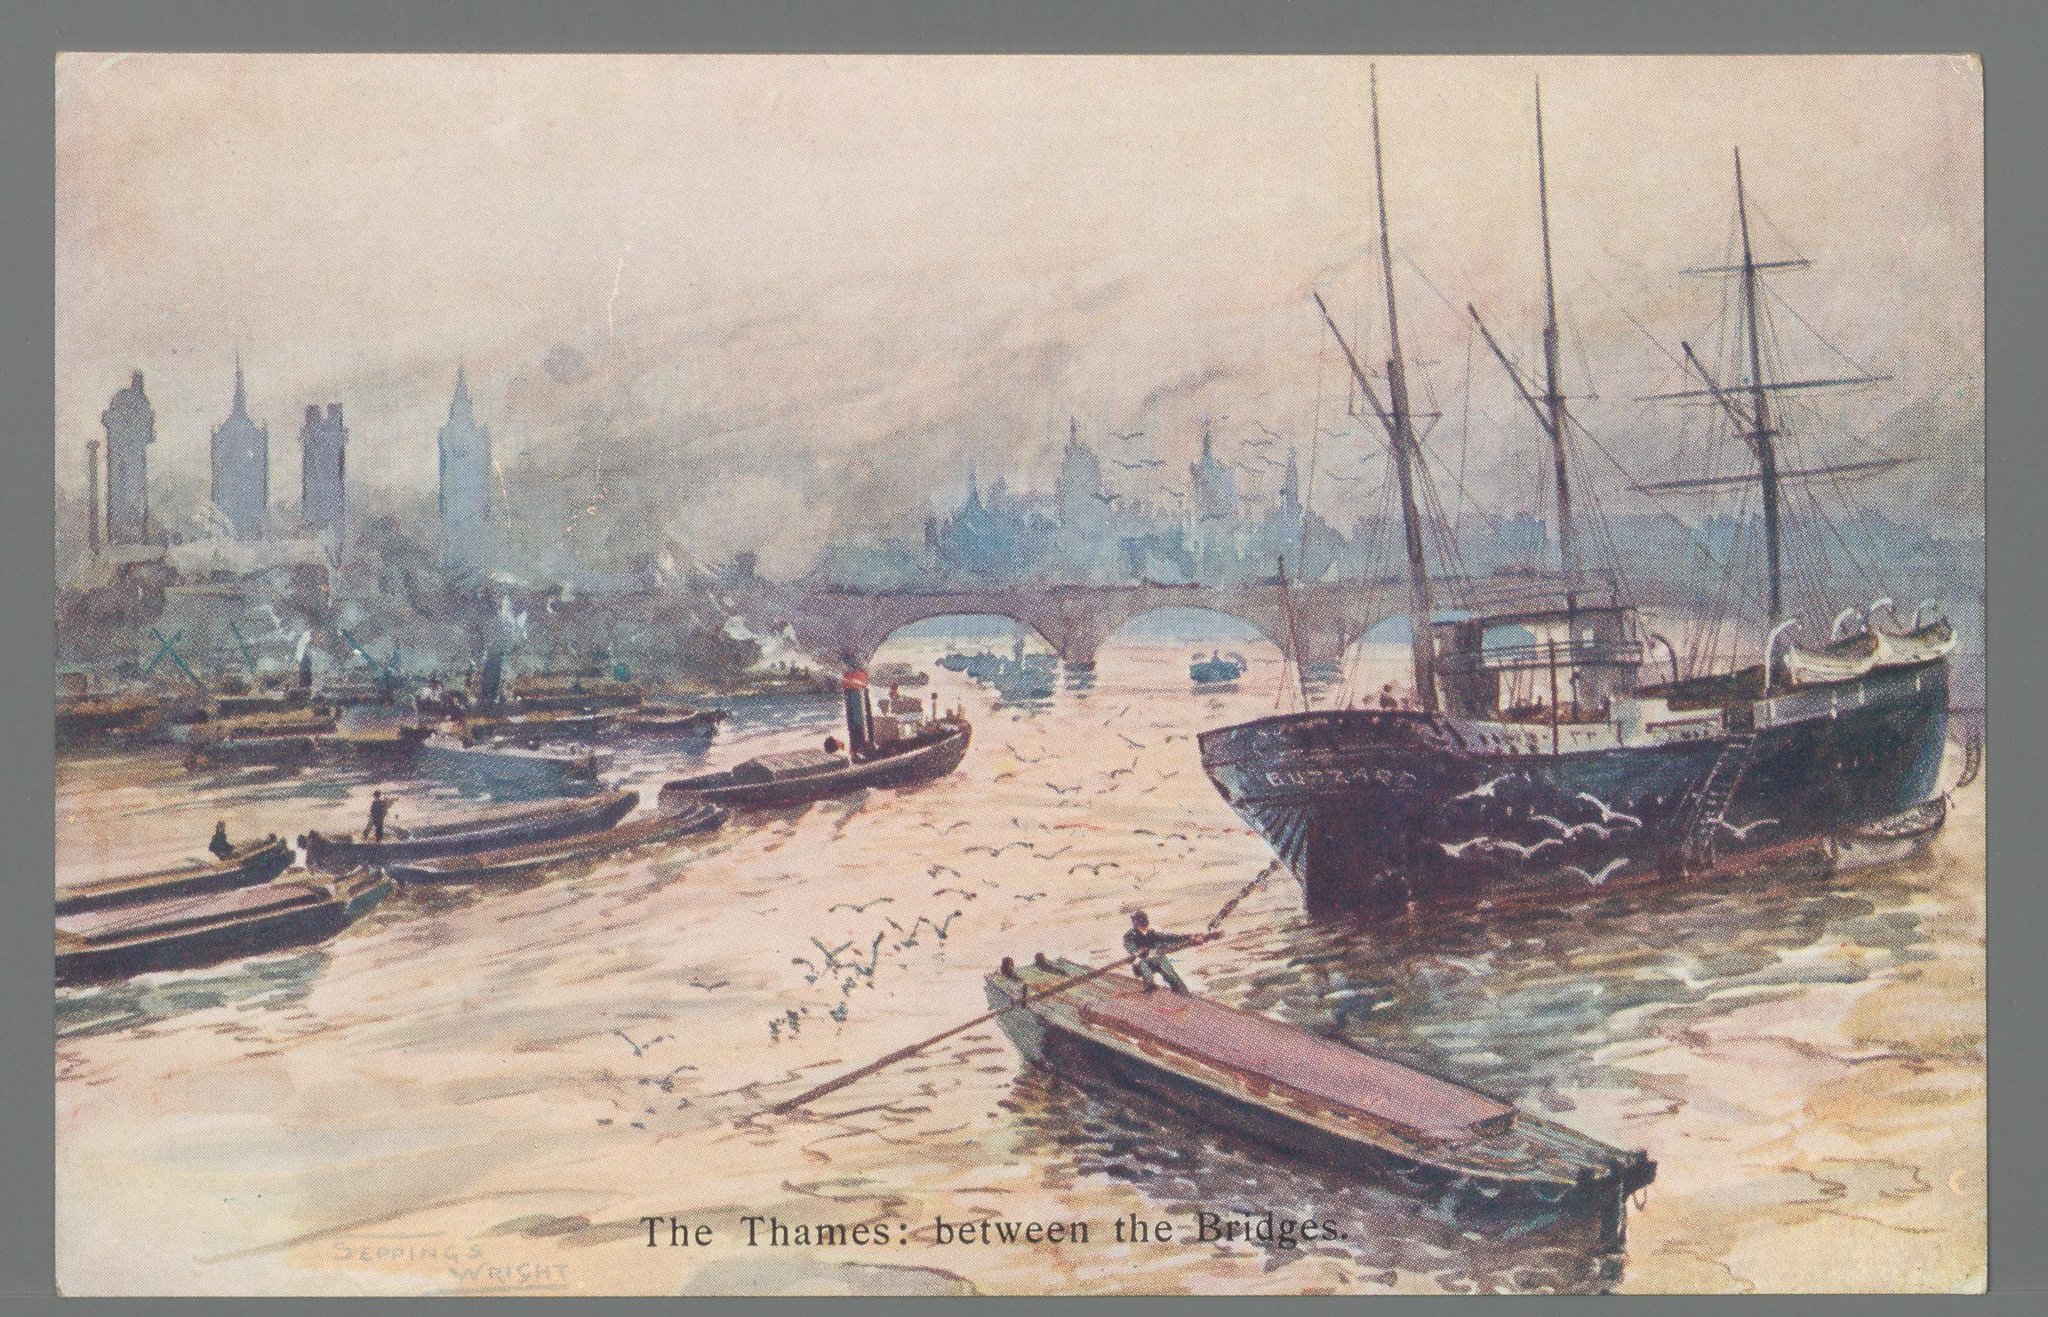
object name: reproduction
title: The Thames: between the bridges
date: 1902-1940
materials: cardboard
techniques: color autotype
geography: london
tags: ships (in general), canals, waters (in city), bridge in city across river, canal, etc., london, thames